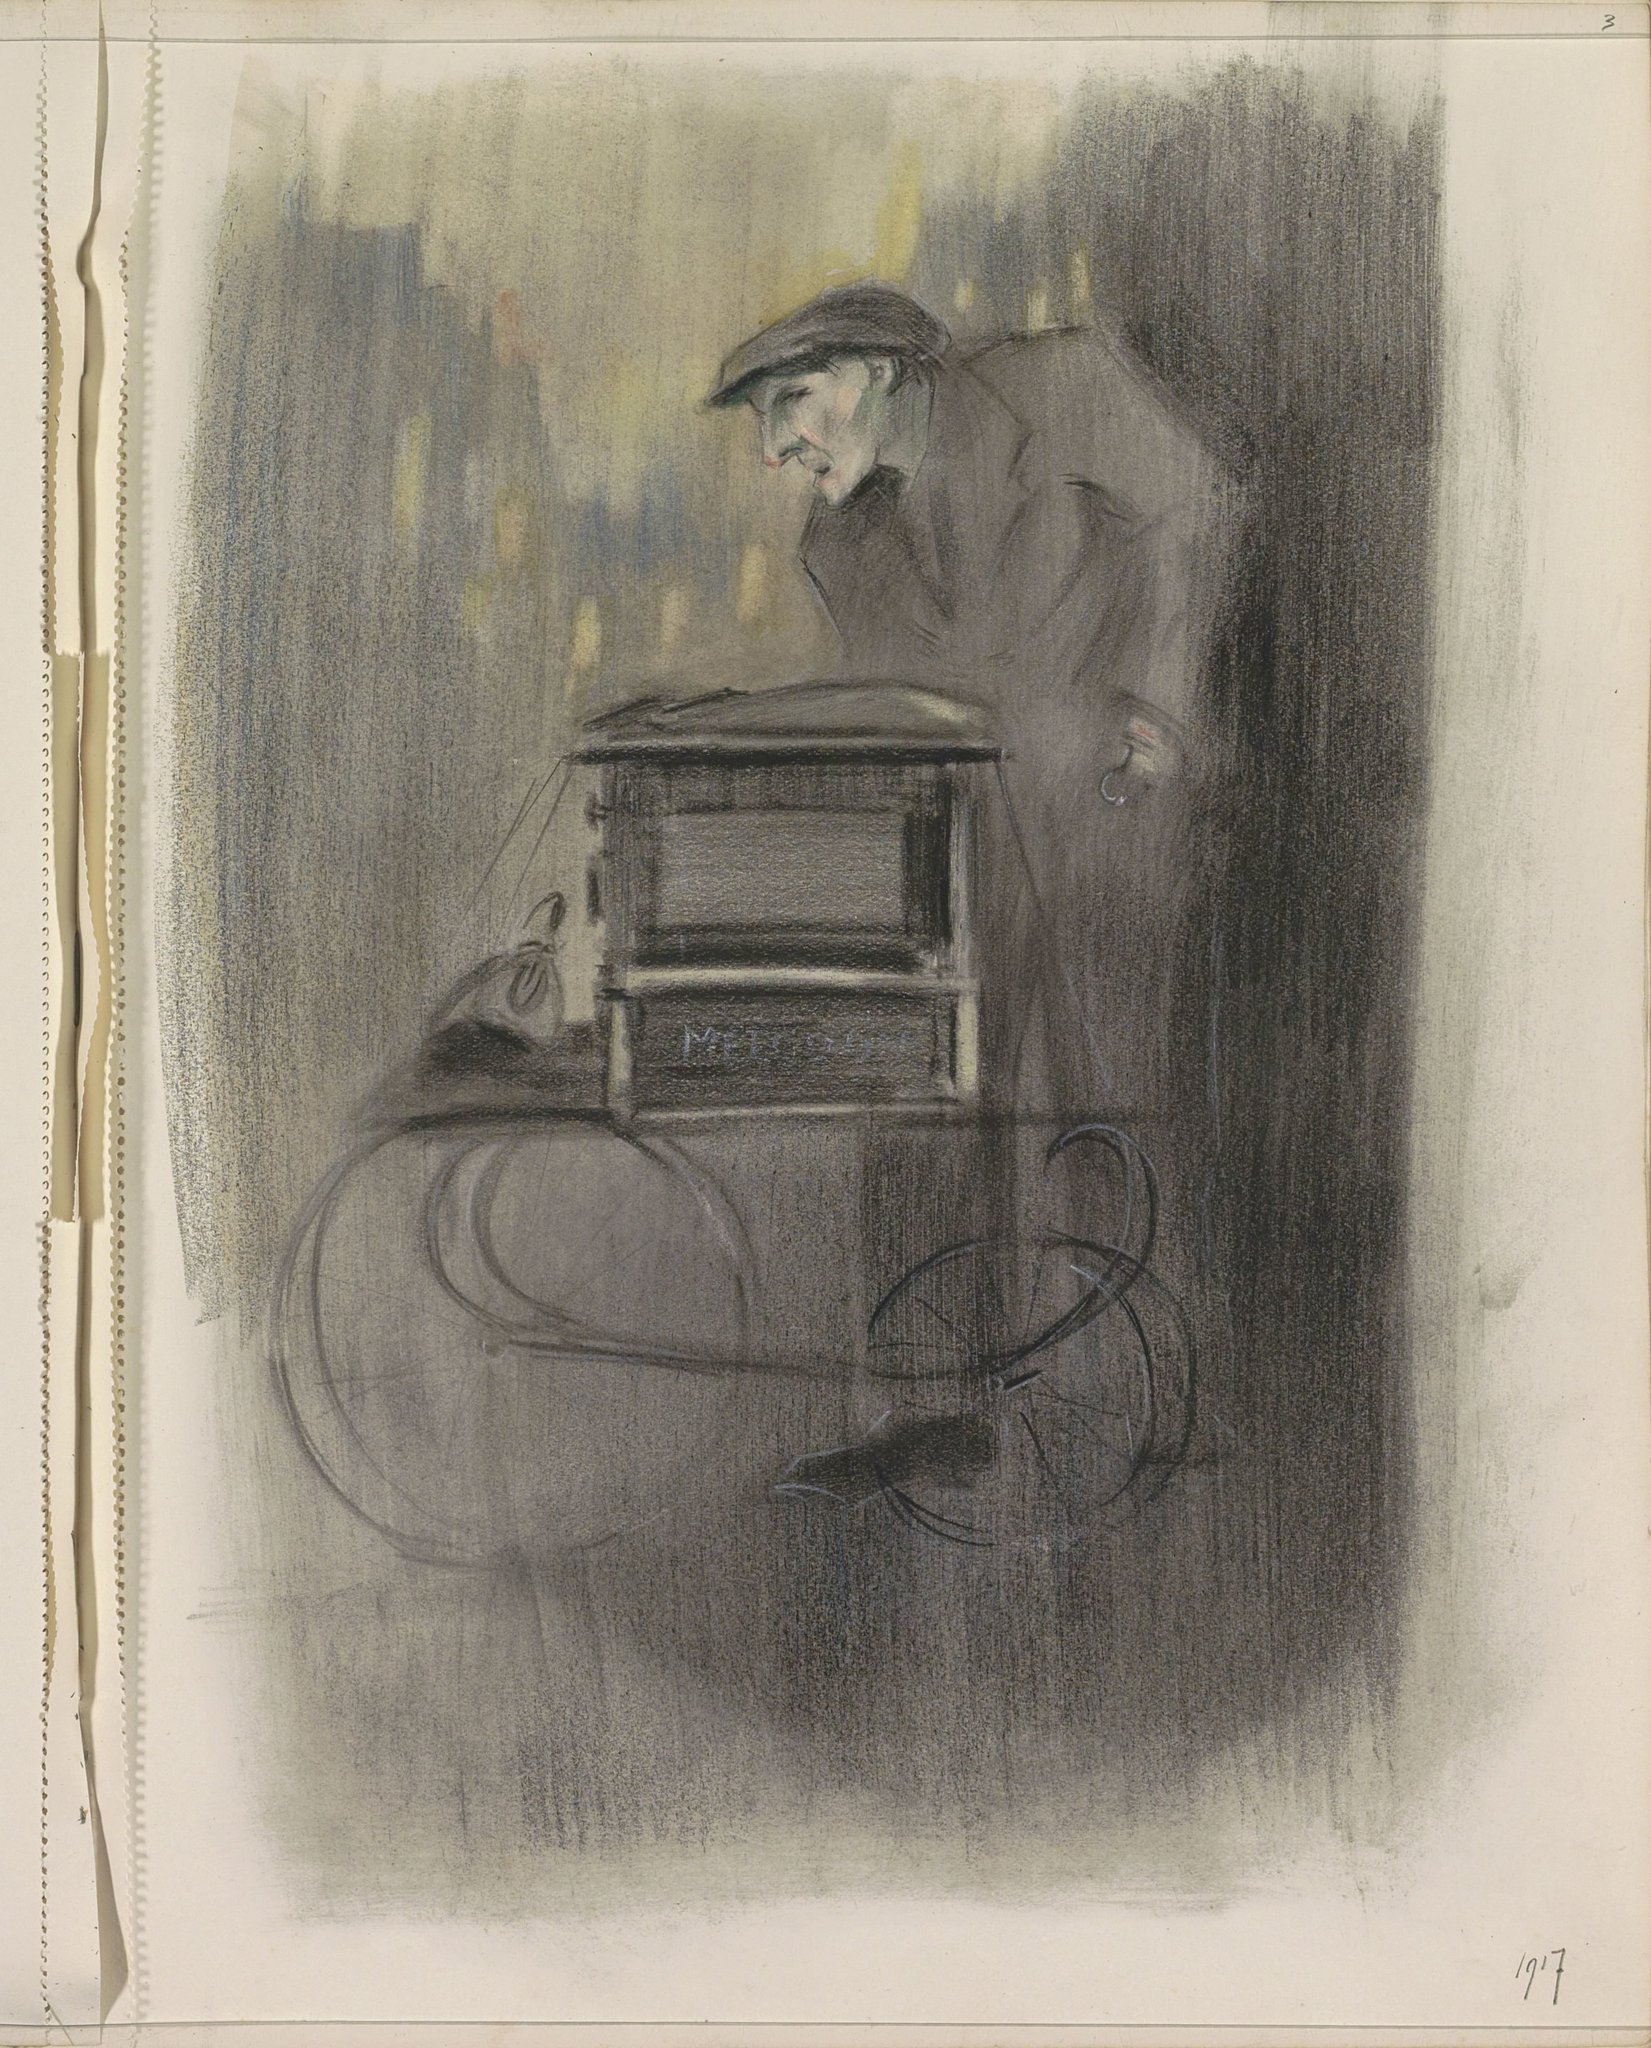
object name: sketchbook leaf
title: Man (vermoedelijk een draaiorgelspeler) op straat bij avond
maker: otto verhagen (i)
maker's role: draughtsman, print maker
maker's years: 1885-1951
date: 1917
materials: chalk, paper, pencil, watercolor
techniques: brush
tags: standing figure, human strength ~ traffic and transport on land, popular music, street music, street lighting, street, barrel-organ player - cc - out of doors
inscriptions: date: ‘1917’, annotation: ‘MELODON’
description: De man draagt een pet en donker pak en heeft een haak in plaats van een linkerhand. Hij duwt een kar met vier wielen voort met daarop een kist, waarschijnlijk een klein draaiorgel. Vermoedelijk een boekillustratie. Pagina 3 uit een schetsboek met 28 bladen.